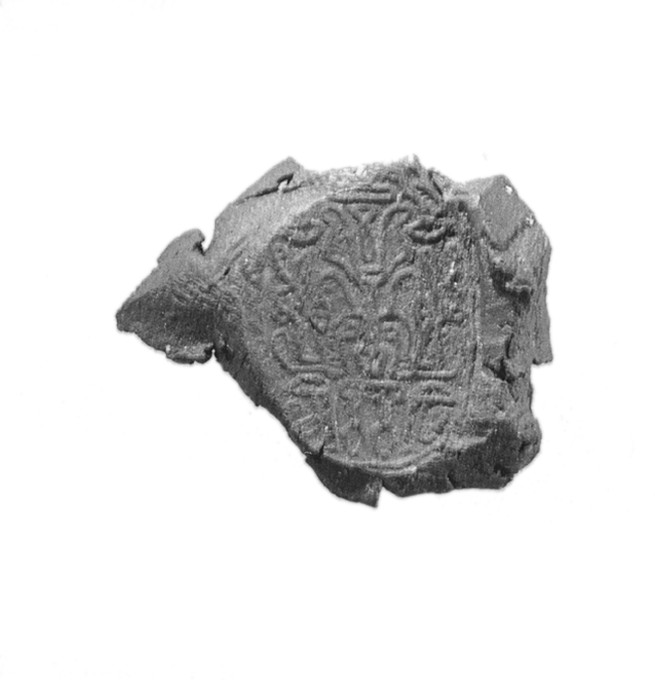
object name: sealing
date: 2030-1640 BCE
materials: clay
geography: egypt